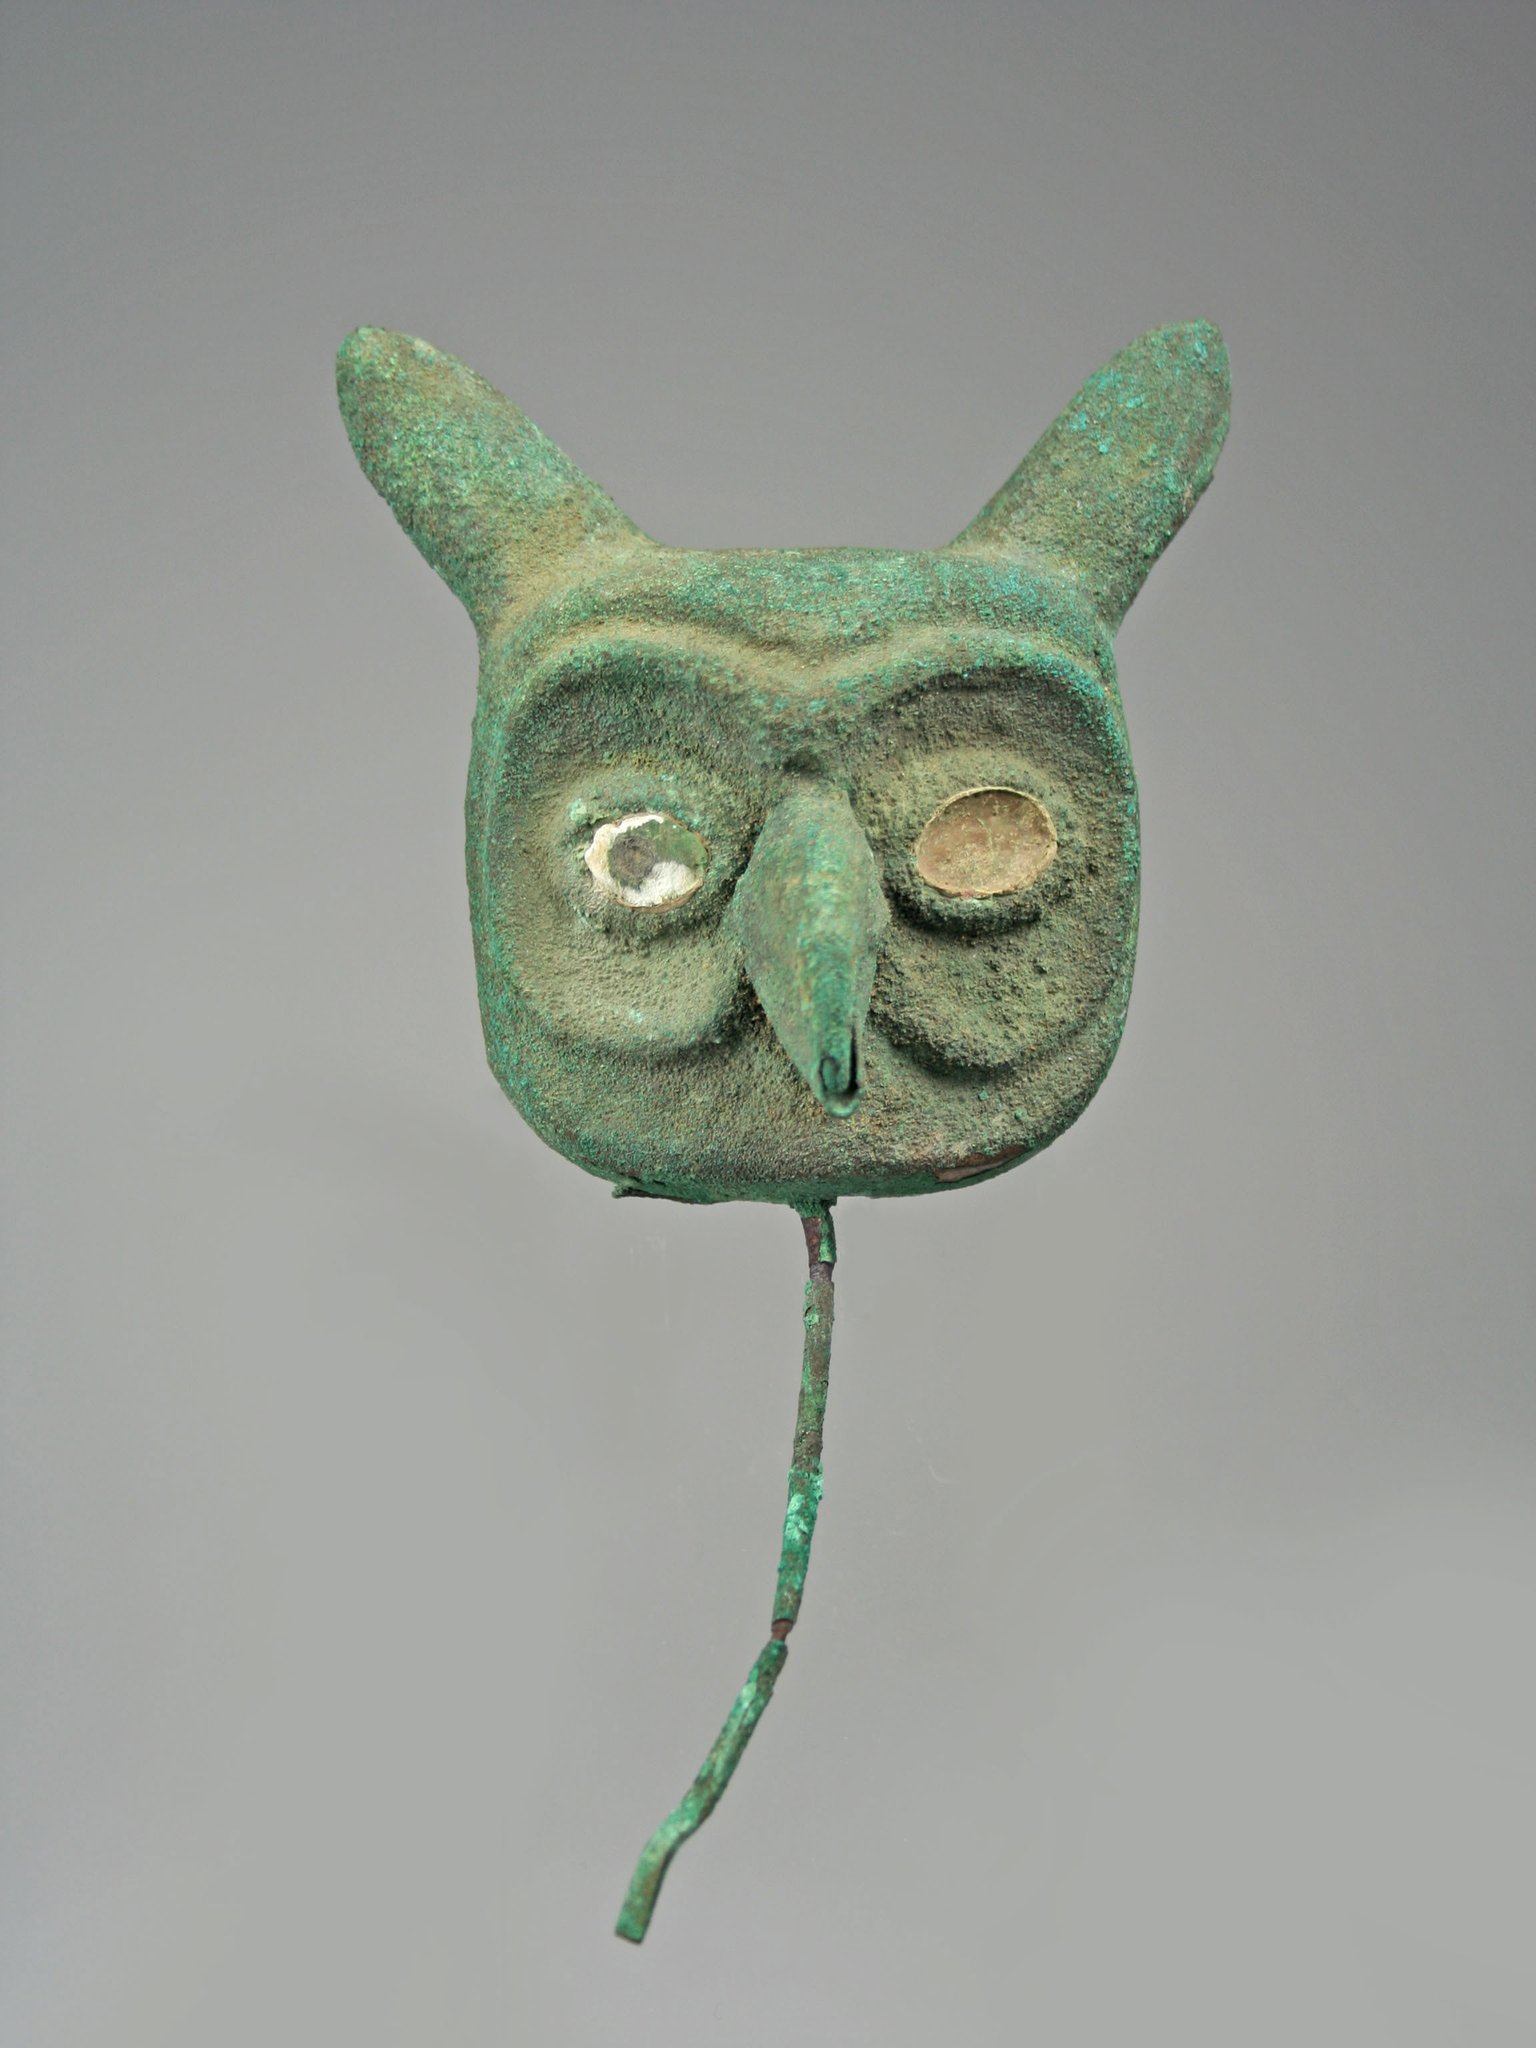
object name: ornament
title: Owl Head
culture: moche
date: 501-700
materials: gilt copper, shell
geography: peru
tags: owls